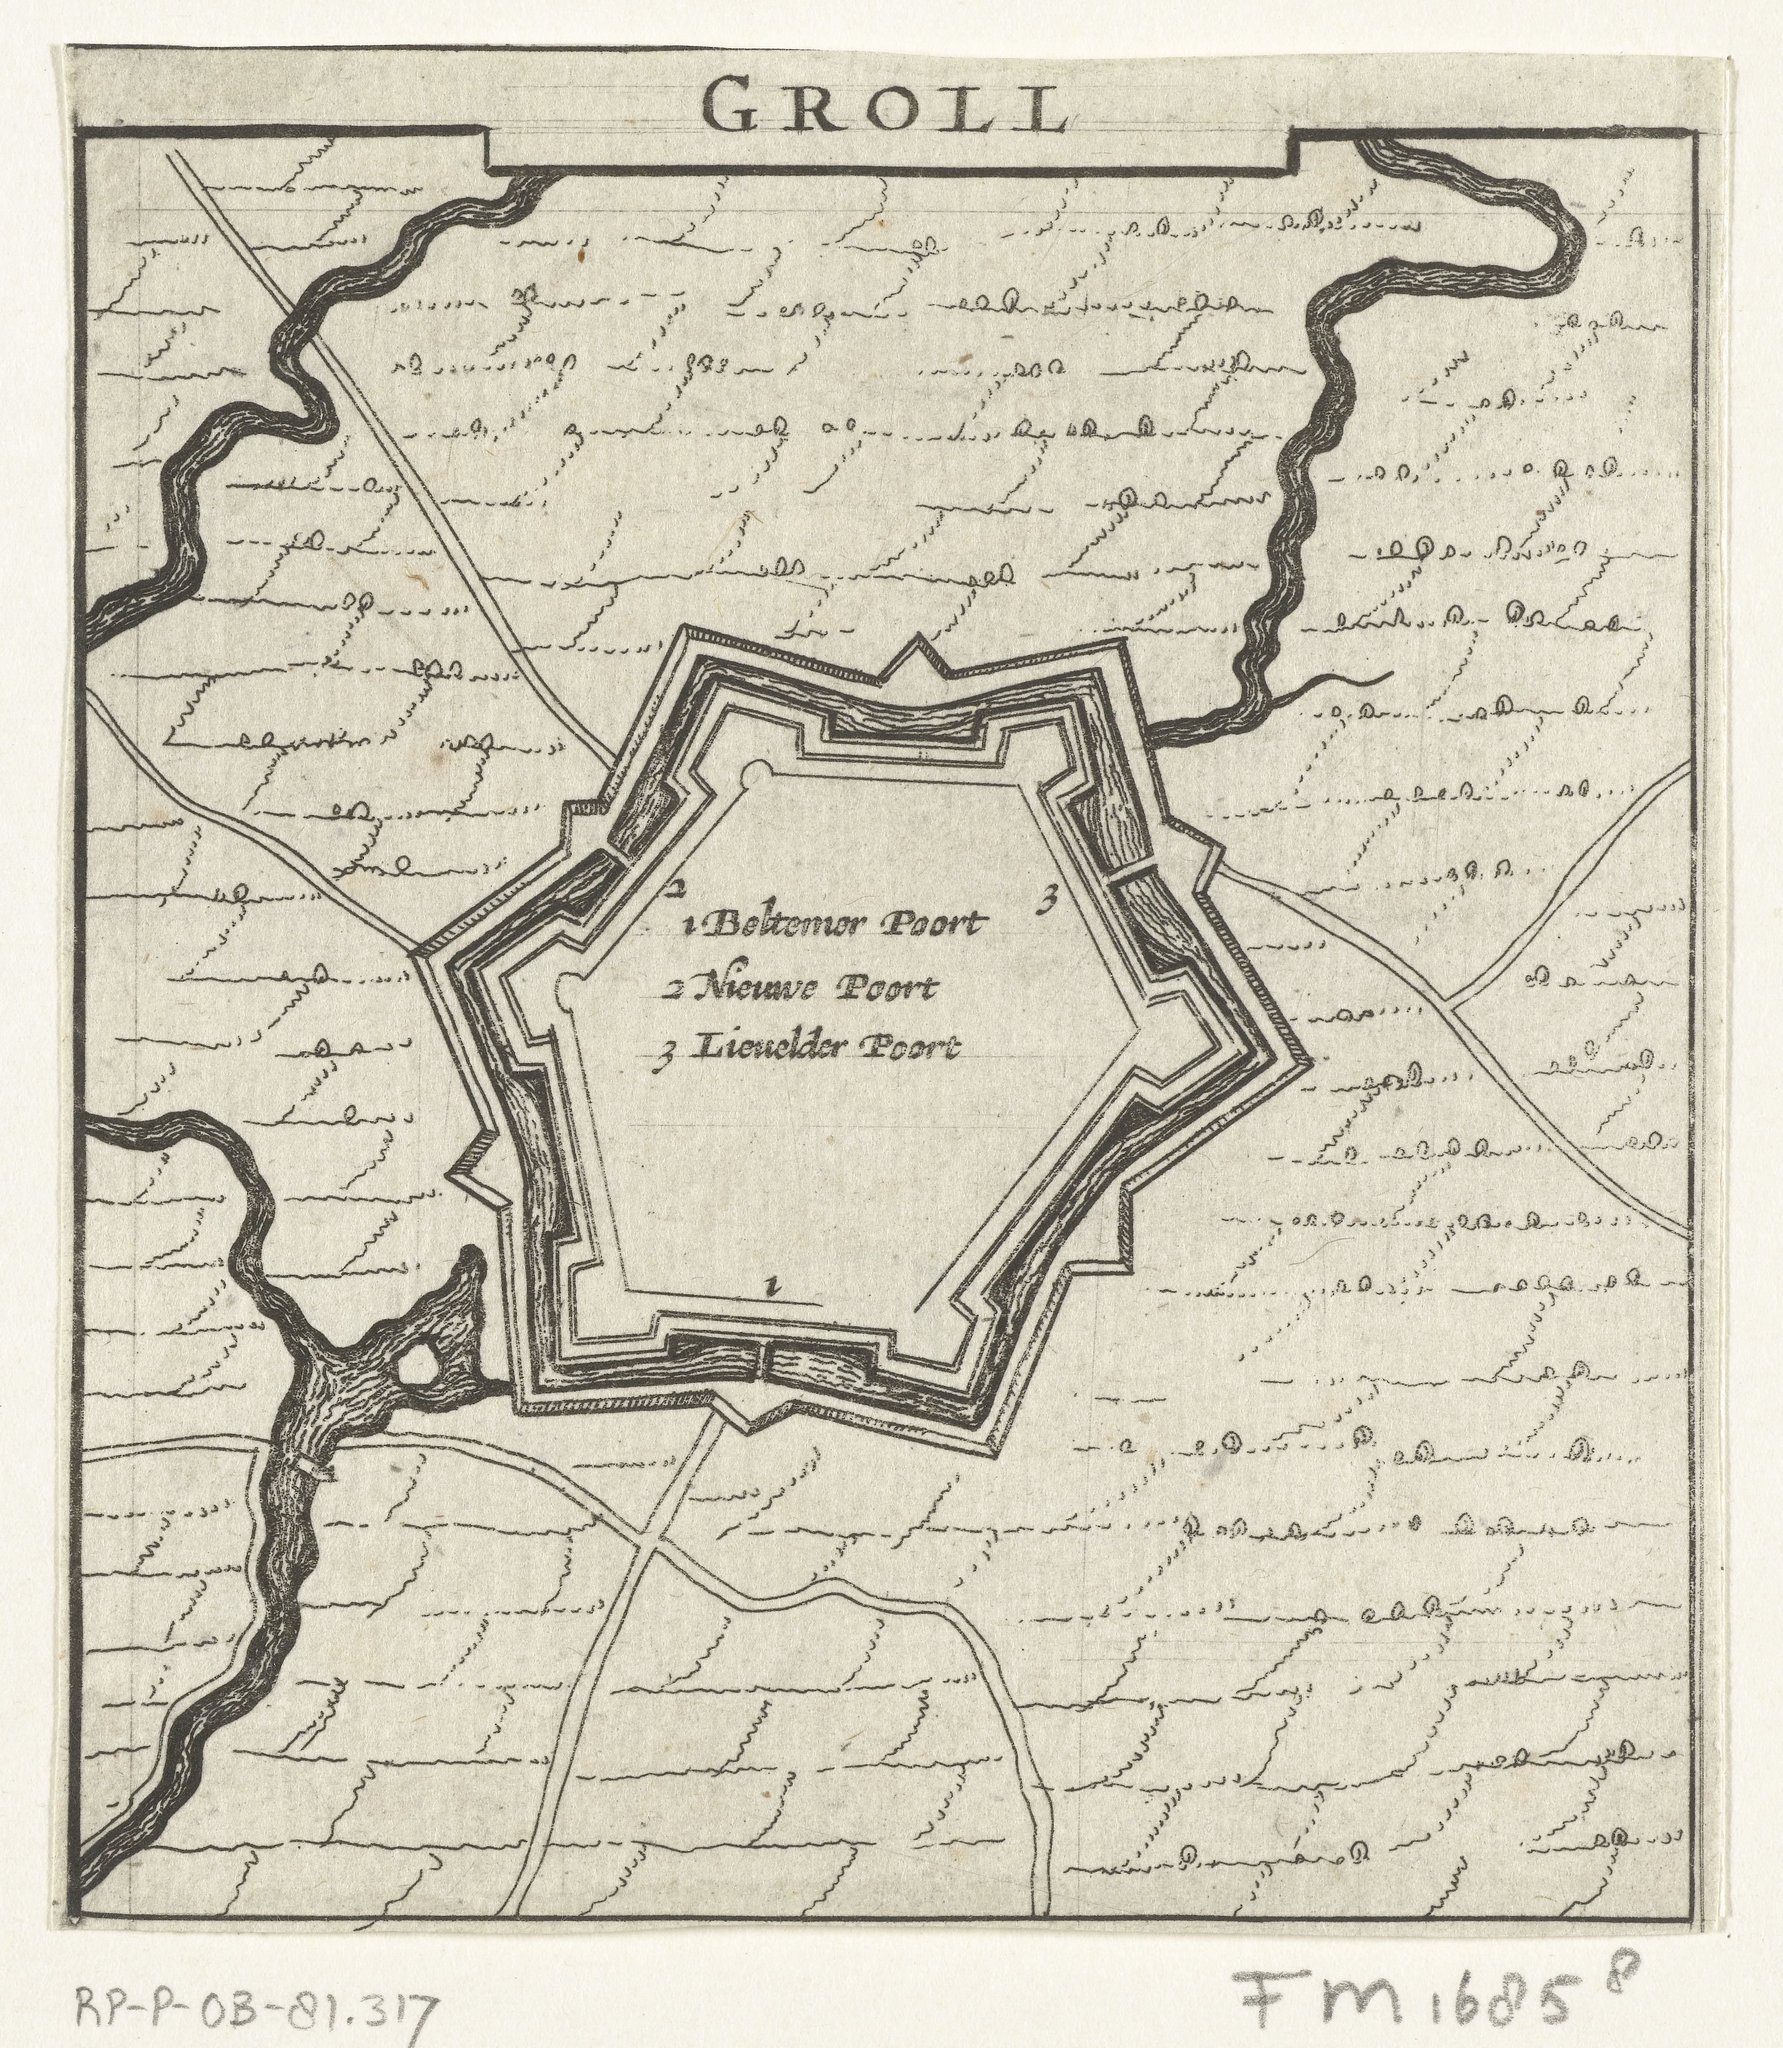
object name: map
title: Plattegrond van Groenlo, 1631-1632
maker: Anonymous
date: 1632-1649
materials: paper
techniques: etching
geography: northern netherlands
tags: maps of cities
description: Plattegrond van Groenlo. Met legenda 1-3. Onderdeel van een groep plattegronden van steden, forten en dijken in Brabant veroverd door het Staatse leger onder Frederik Hendrik in de jaren 1631-1632.